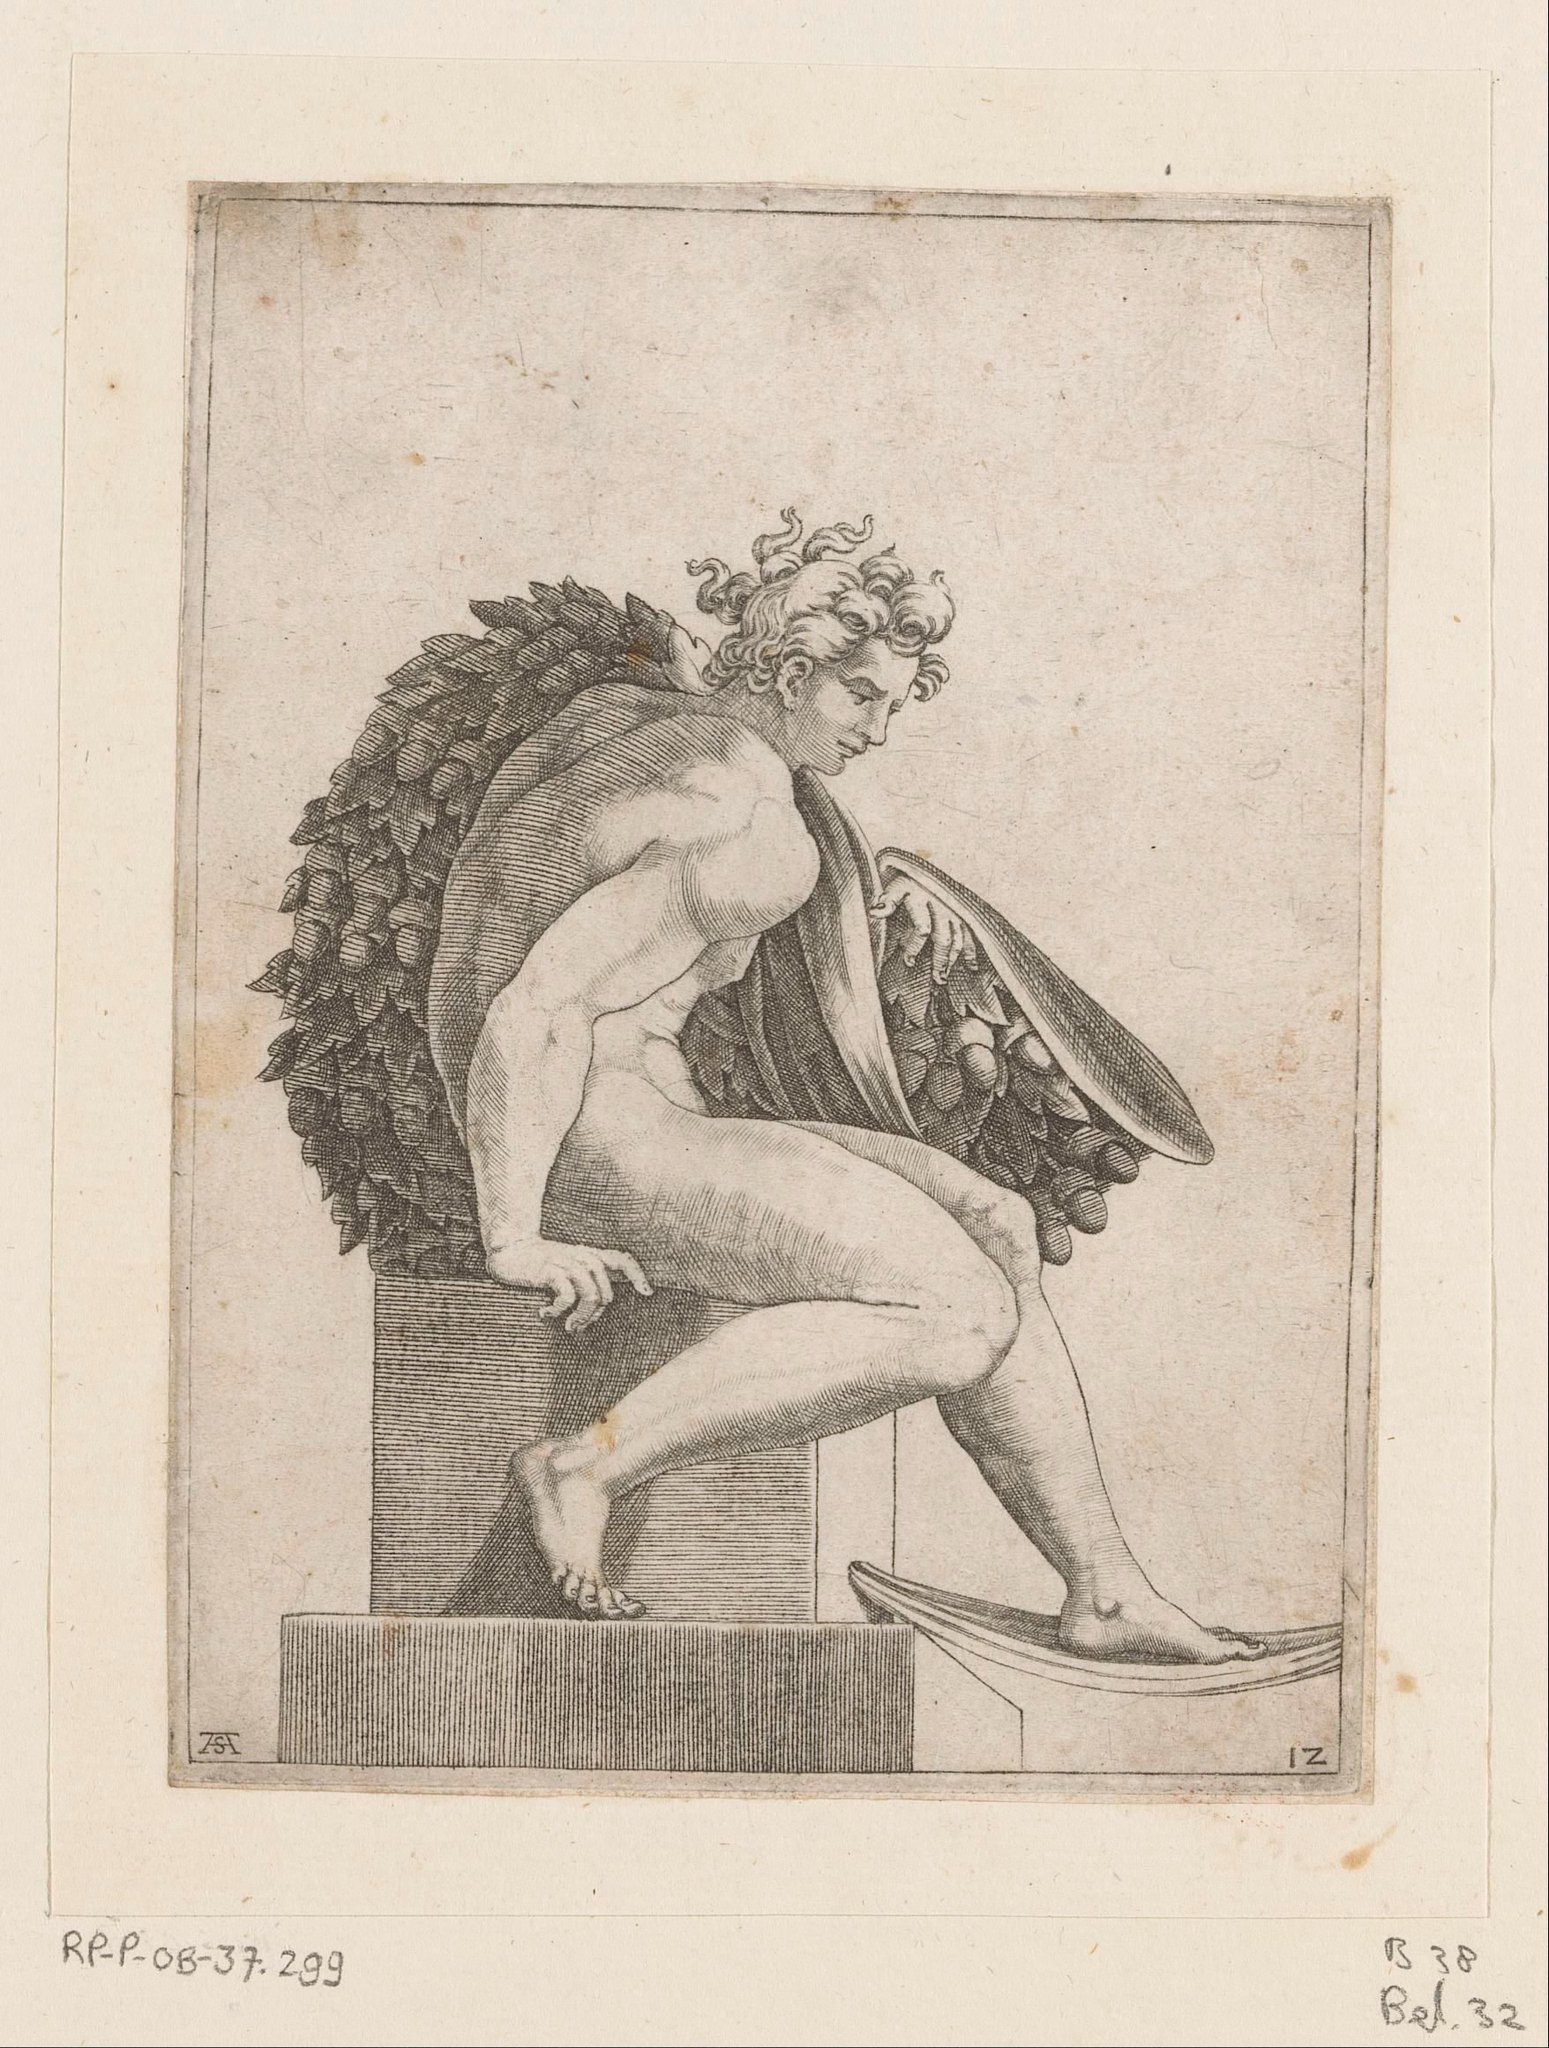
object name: print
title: Schilderingen in de Sixtijnse kapel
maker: adamo scultori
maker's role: painter, print maker, sculptor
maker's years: 1530-1585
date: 1585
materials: paper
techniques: engraving, intaglio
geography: italy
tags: the (nude) human figure; 'corpo humano' (ripa), fruits: acorn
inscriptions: collector's mark: Lugt 240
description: Zittende naakte man, naar rechts gedraaid, met over zijn schouder een guirlande van eikels. Eén van de 'ignudi' (naakte mannen) van Michelangelo's plafondschildering. Genummerd rechtsonder: 12.